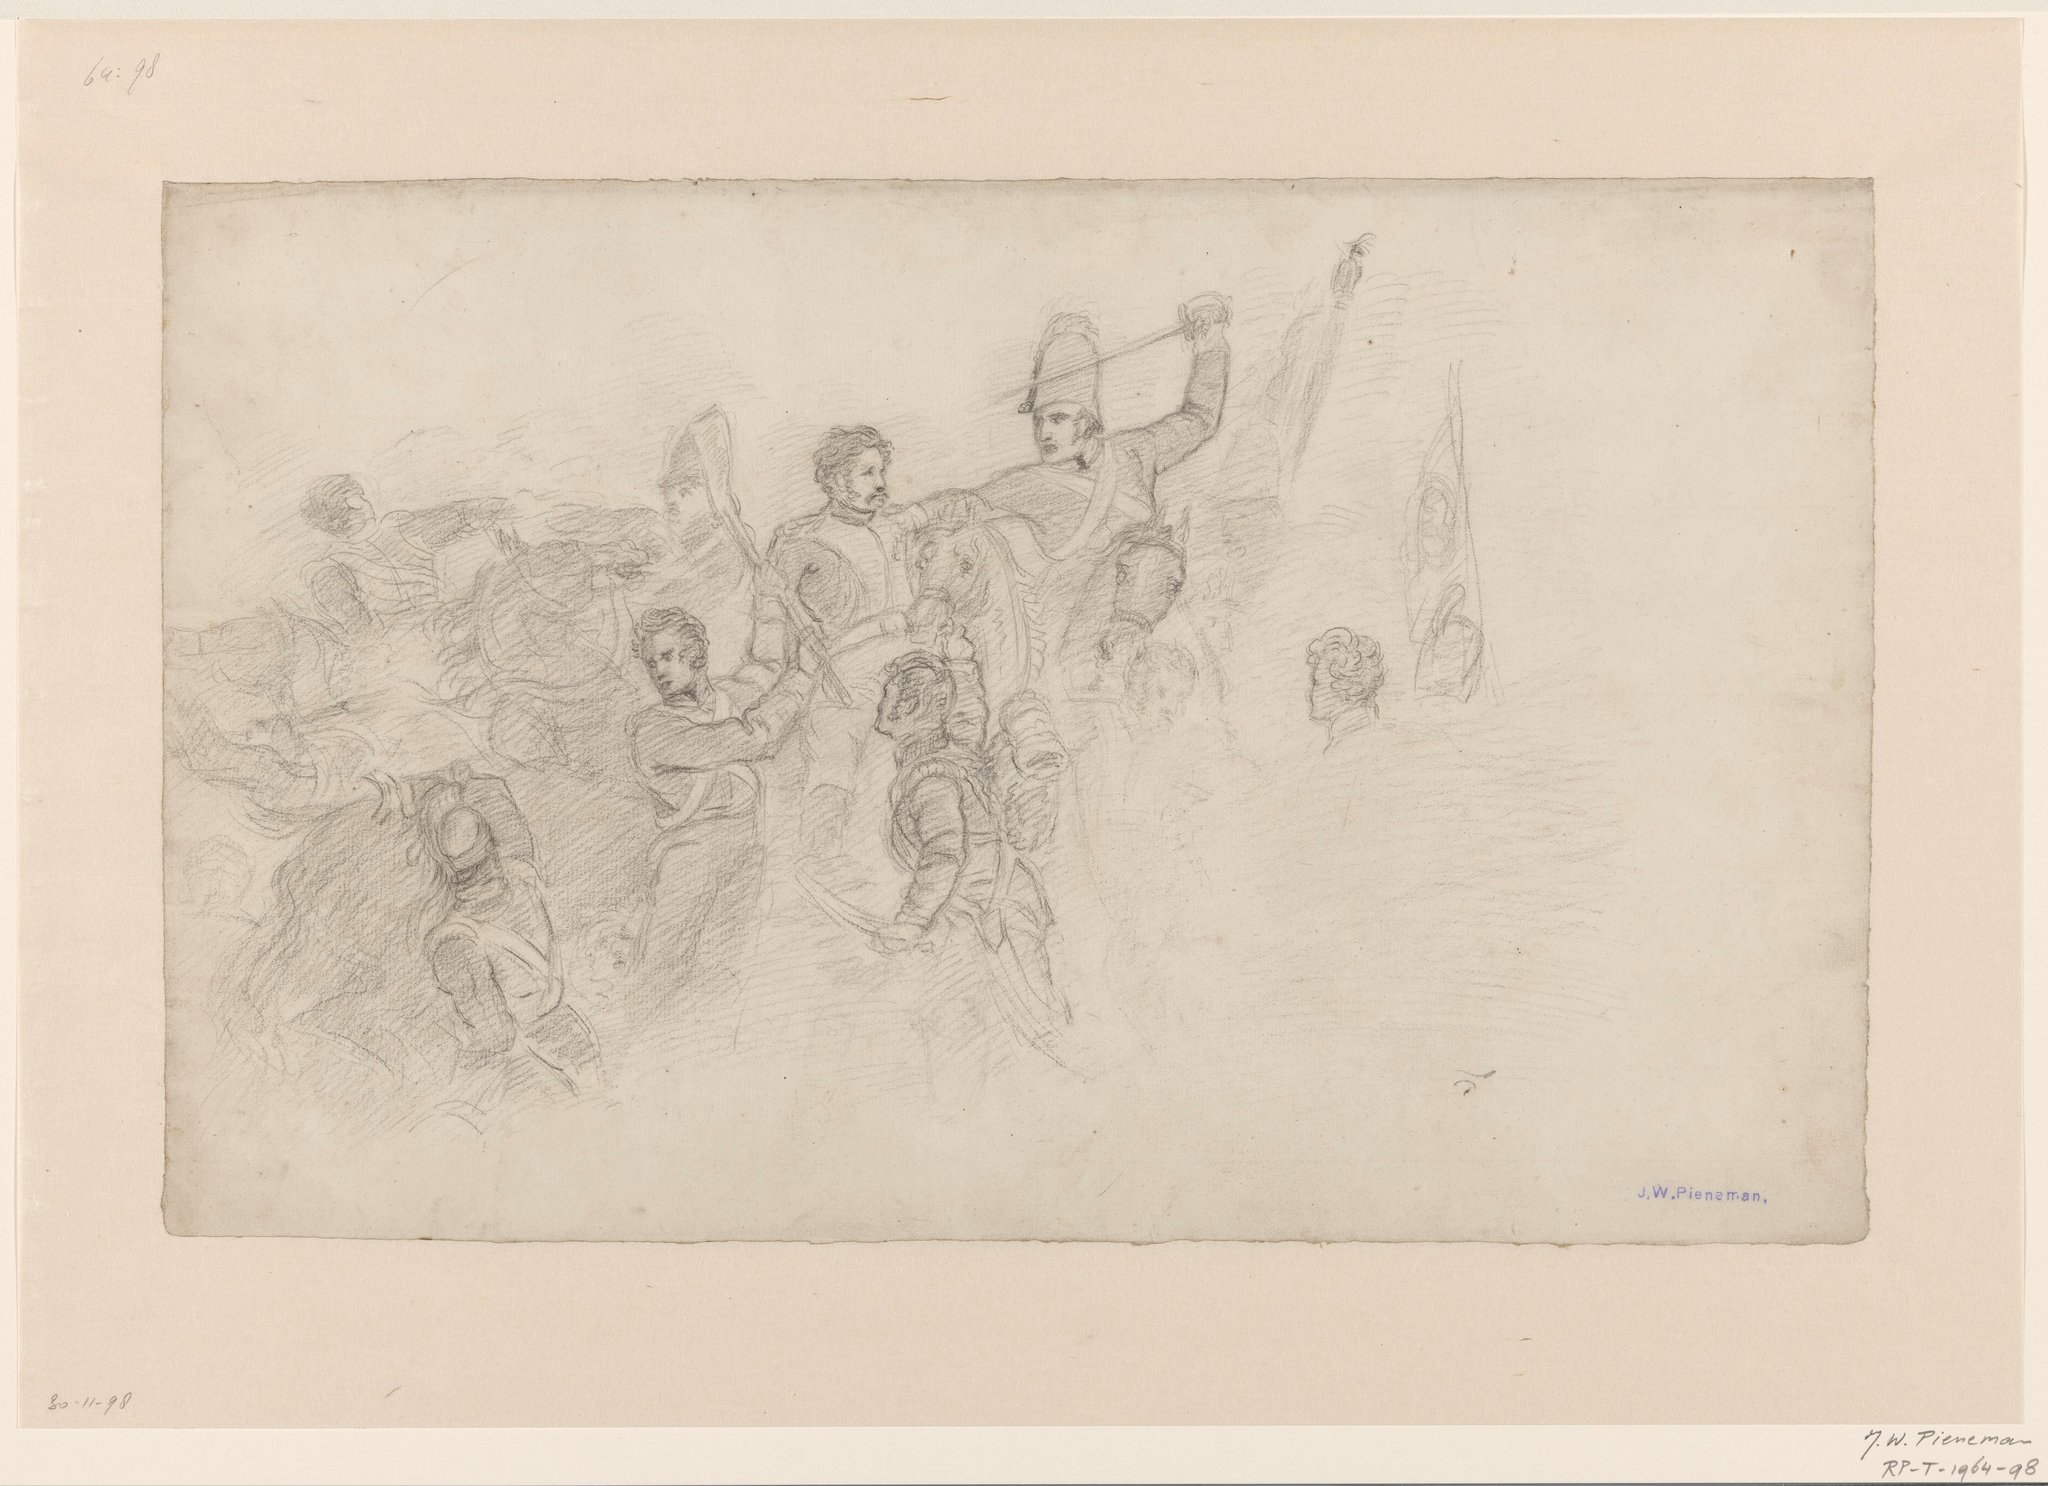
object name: drawing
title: Detail uit het schilderij De Slag bij Waterloo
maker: jan willem pieneman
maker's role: draughtsman, painter, print maker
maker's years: 1779-1853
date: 1789-1853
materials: chalk, paper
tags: battle (+ land forces), historical events and situations